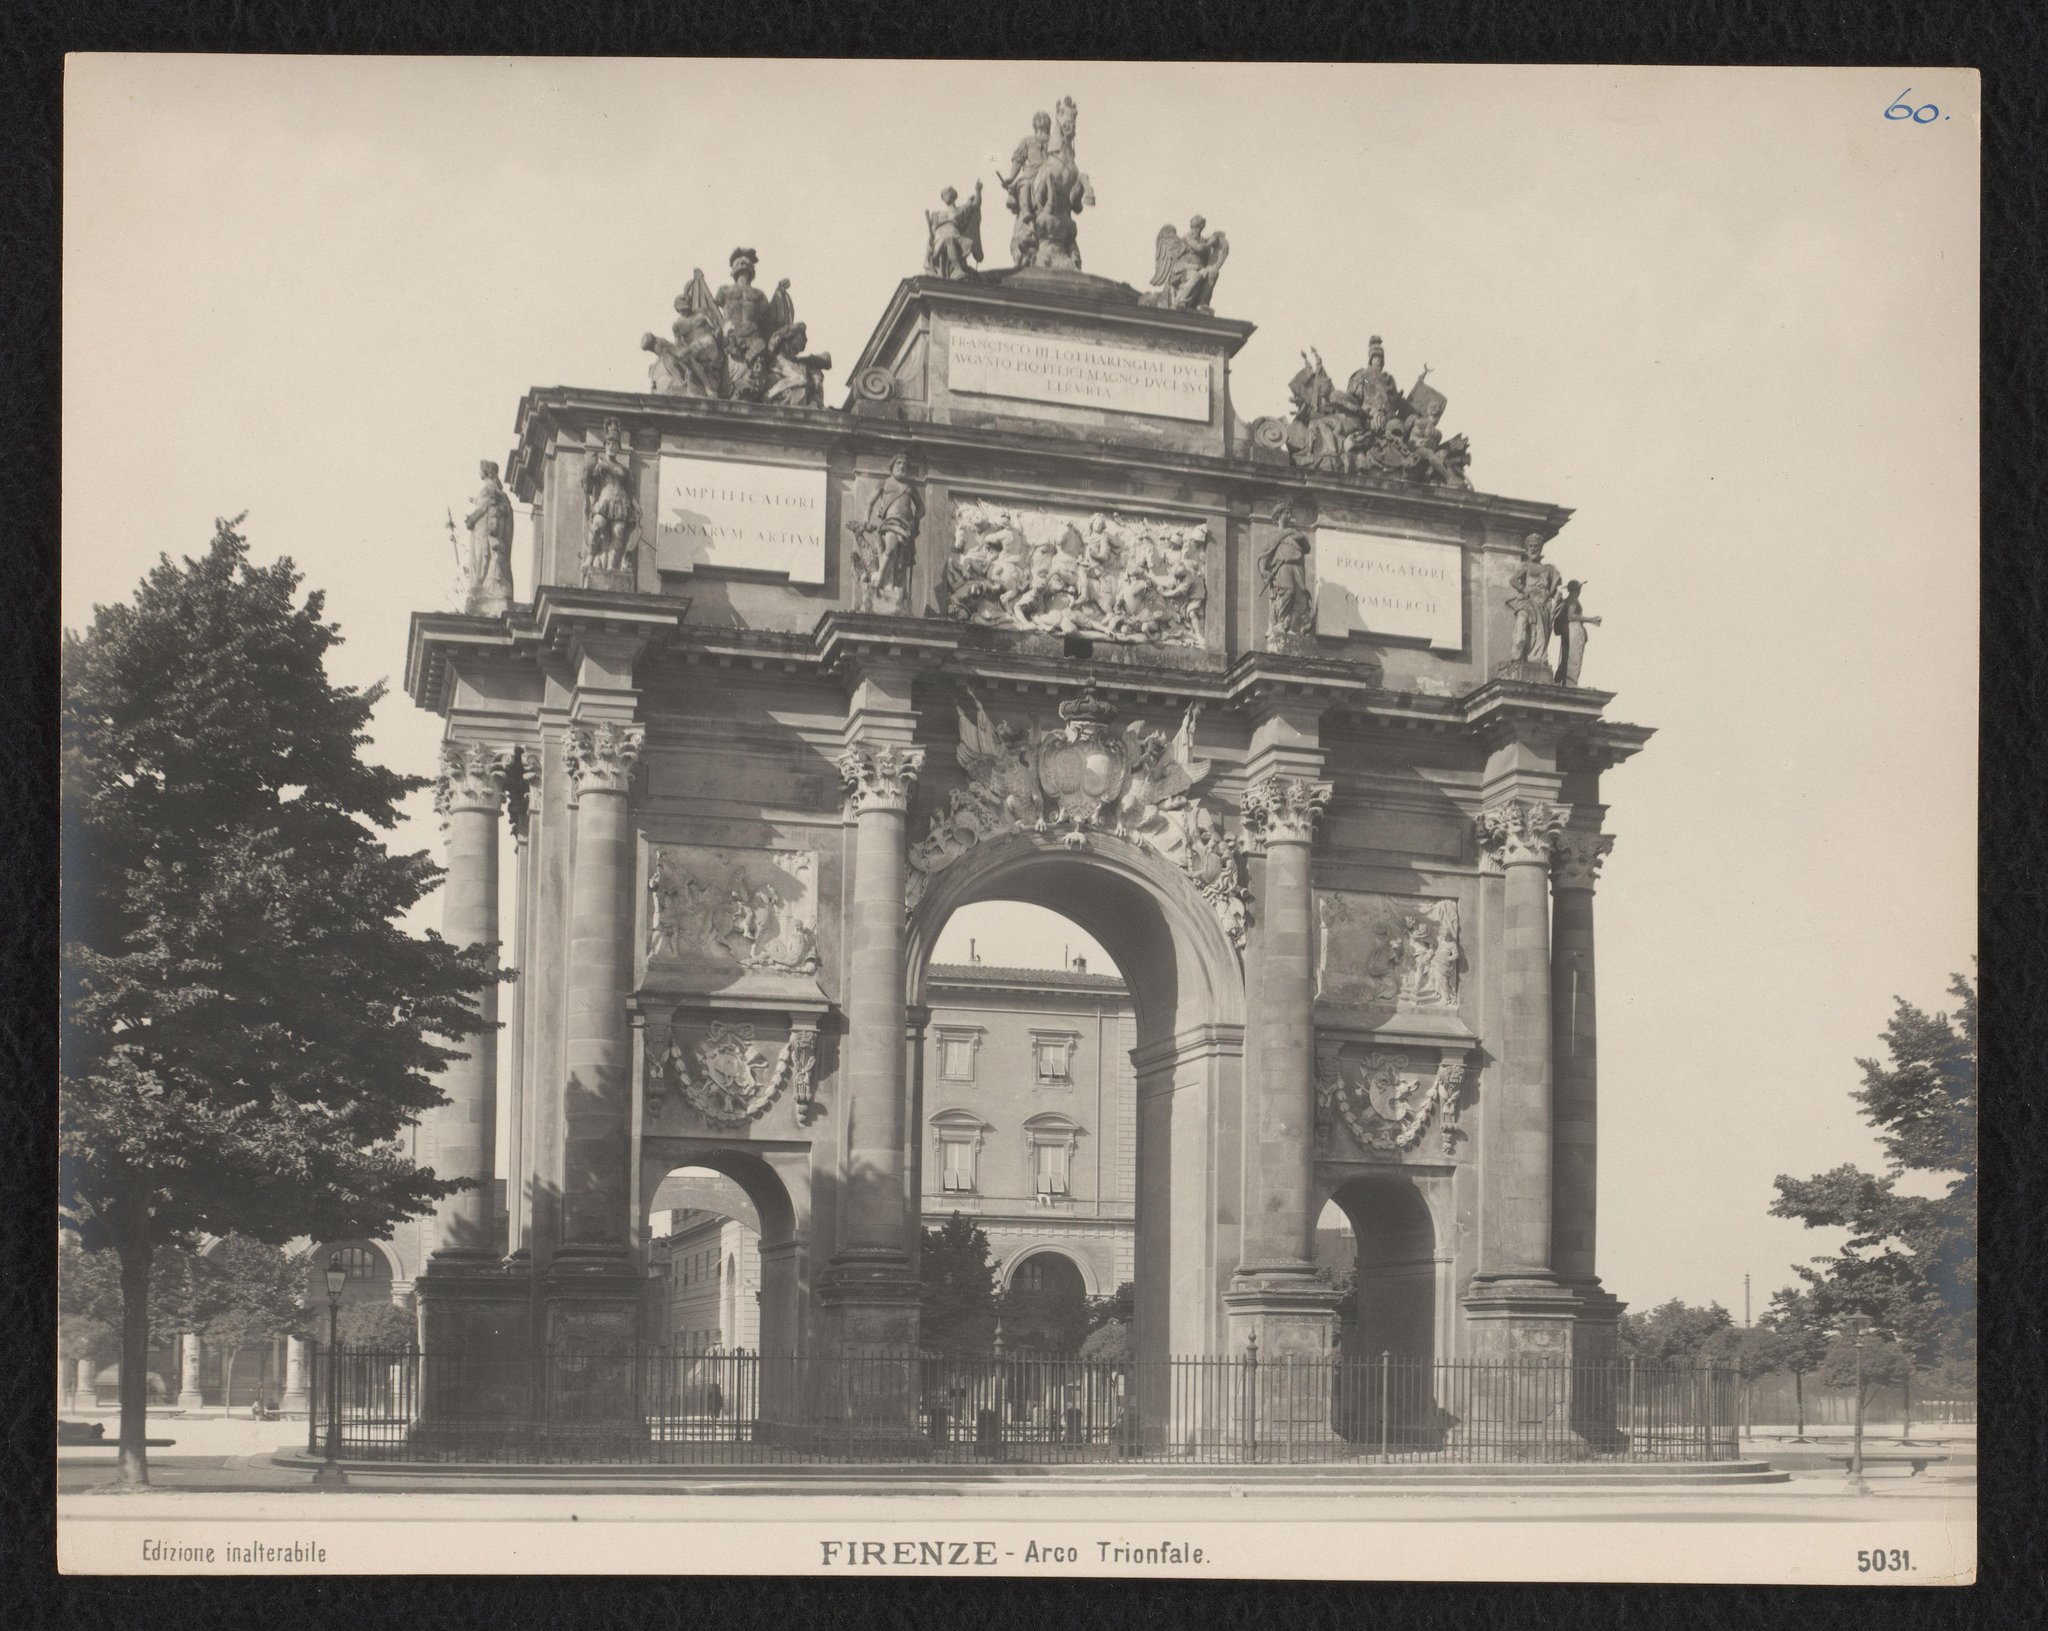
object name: photograph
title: Firenze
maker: Anonymous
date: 1901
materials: paper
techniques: gelatin silver print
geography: berlin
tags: triumphal arch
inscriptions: inscription: ‘Edizione inalterabile.’, number: ‘5031.’, number: ‘60.’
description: Deze foto maakt deel uit van een omslag.